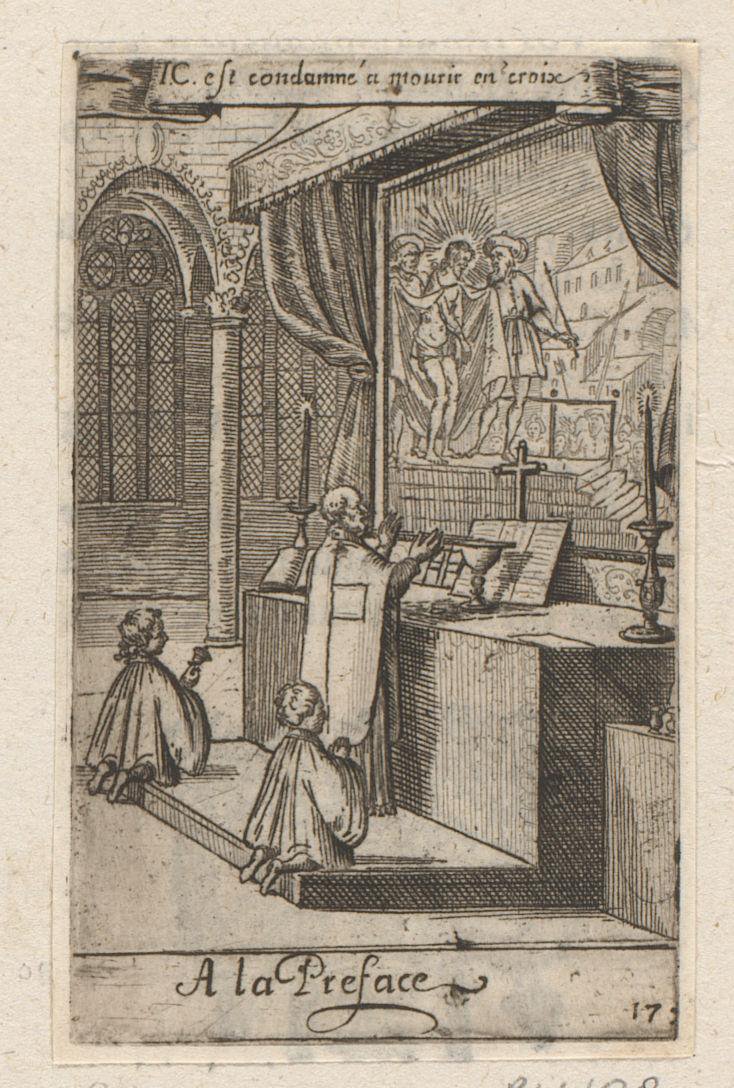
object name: print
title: A la Preface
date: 1661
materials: paper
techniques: etching, letterpress printing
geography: france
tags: priest (roman catholic), altar with altar-piece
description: Prent uit: Mengin, L. Tableaux ou sont representees la passion de N.S. Christ et les actions du prestre a la S. Messe (...). Metz: Claude Bouchard, 1661.